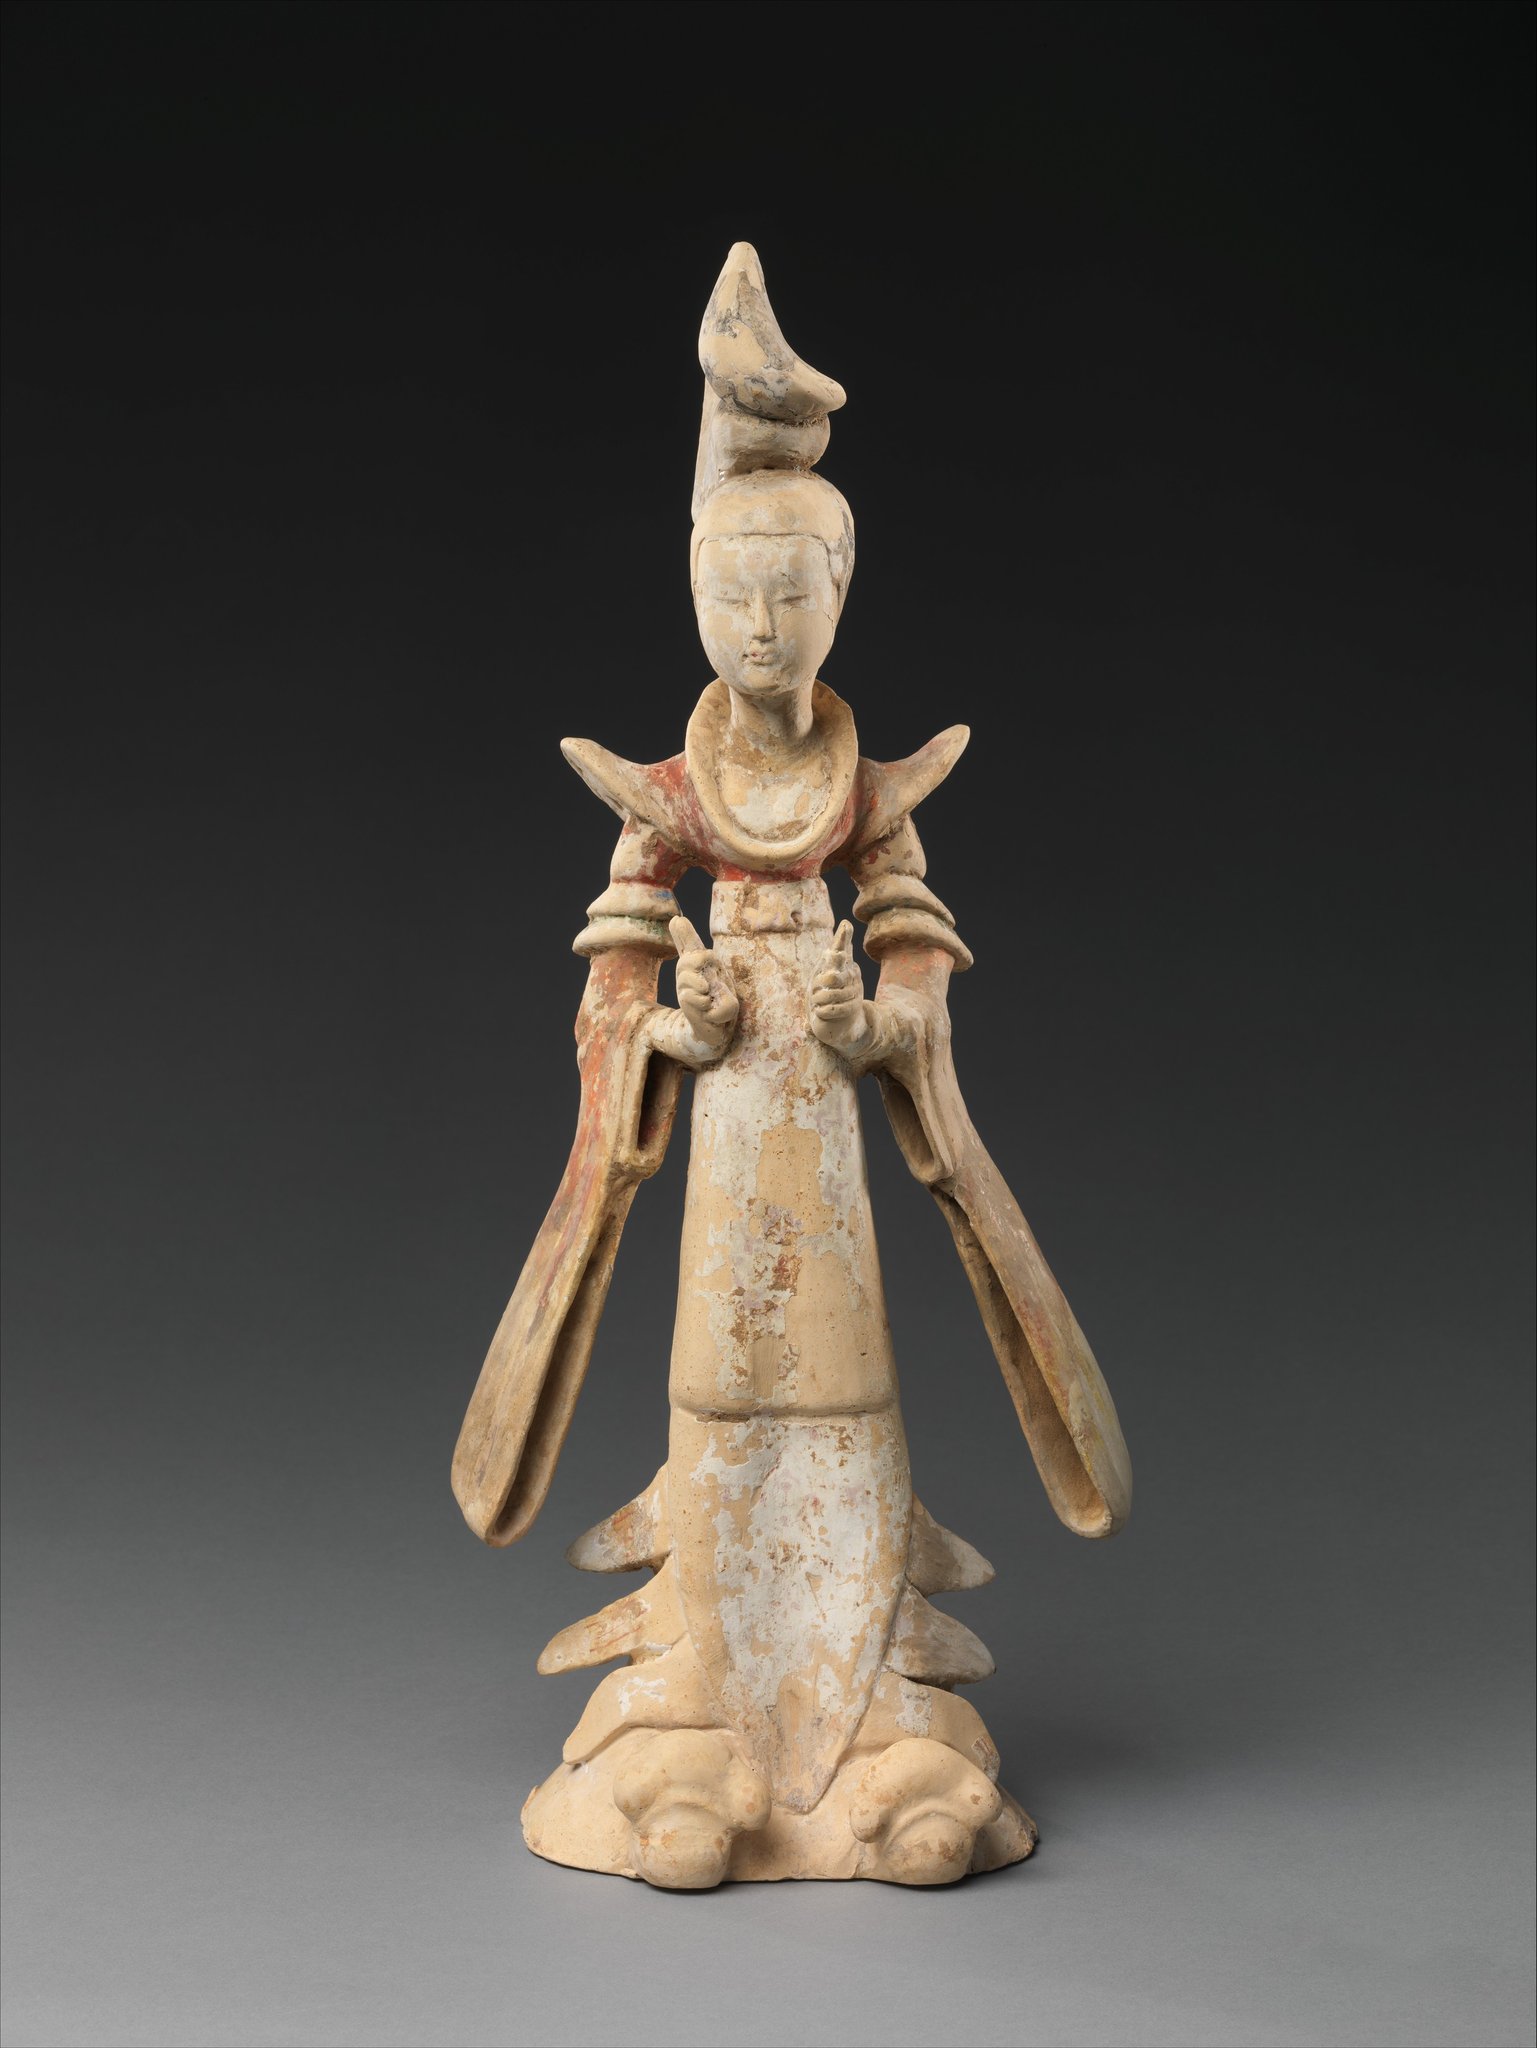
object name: figure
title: Standing court lady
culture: chinese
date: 601-800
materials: earthenware, pigment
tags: women